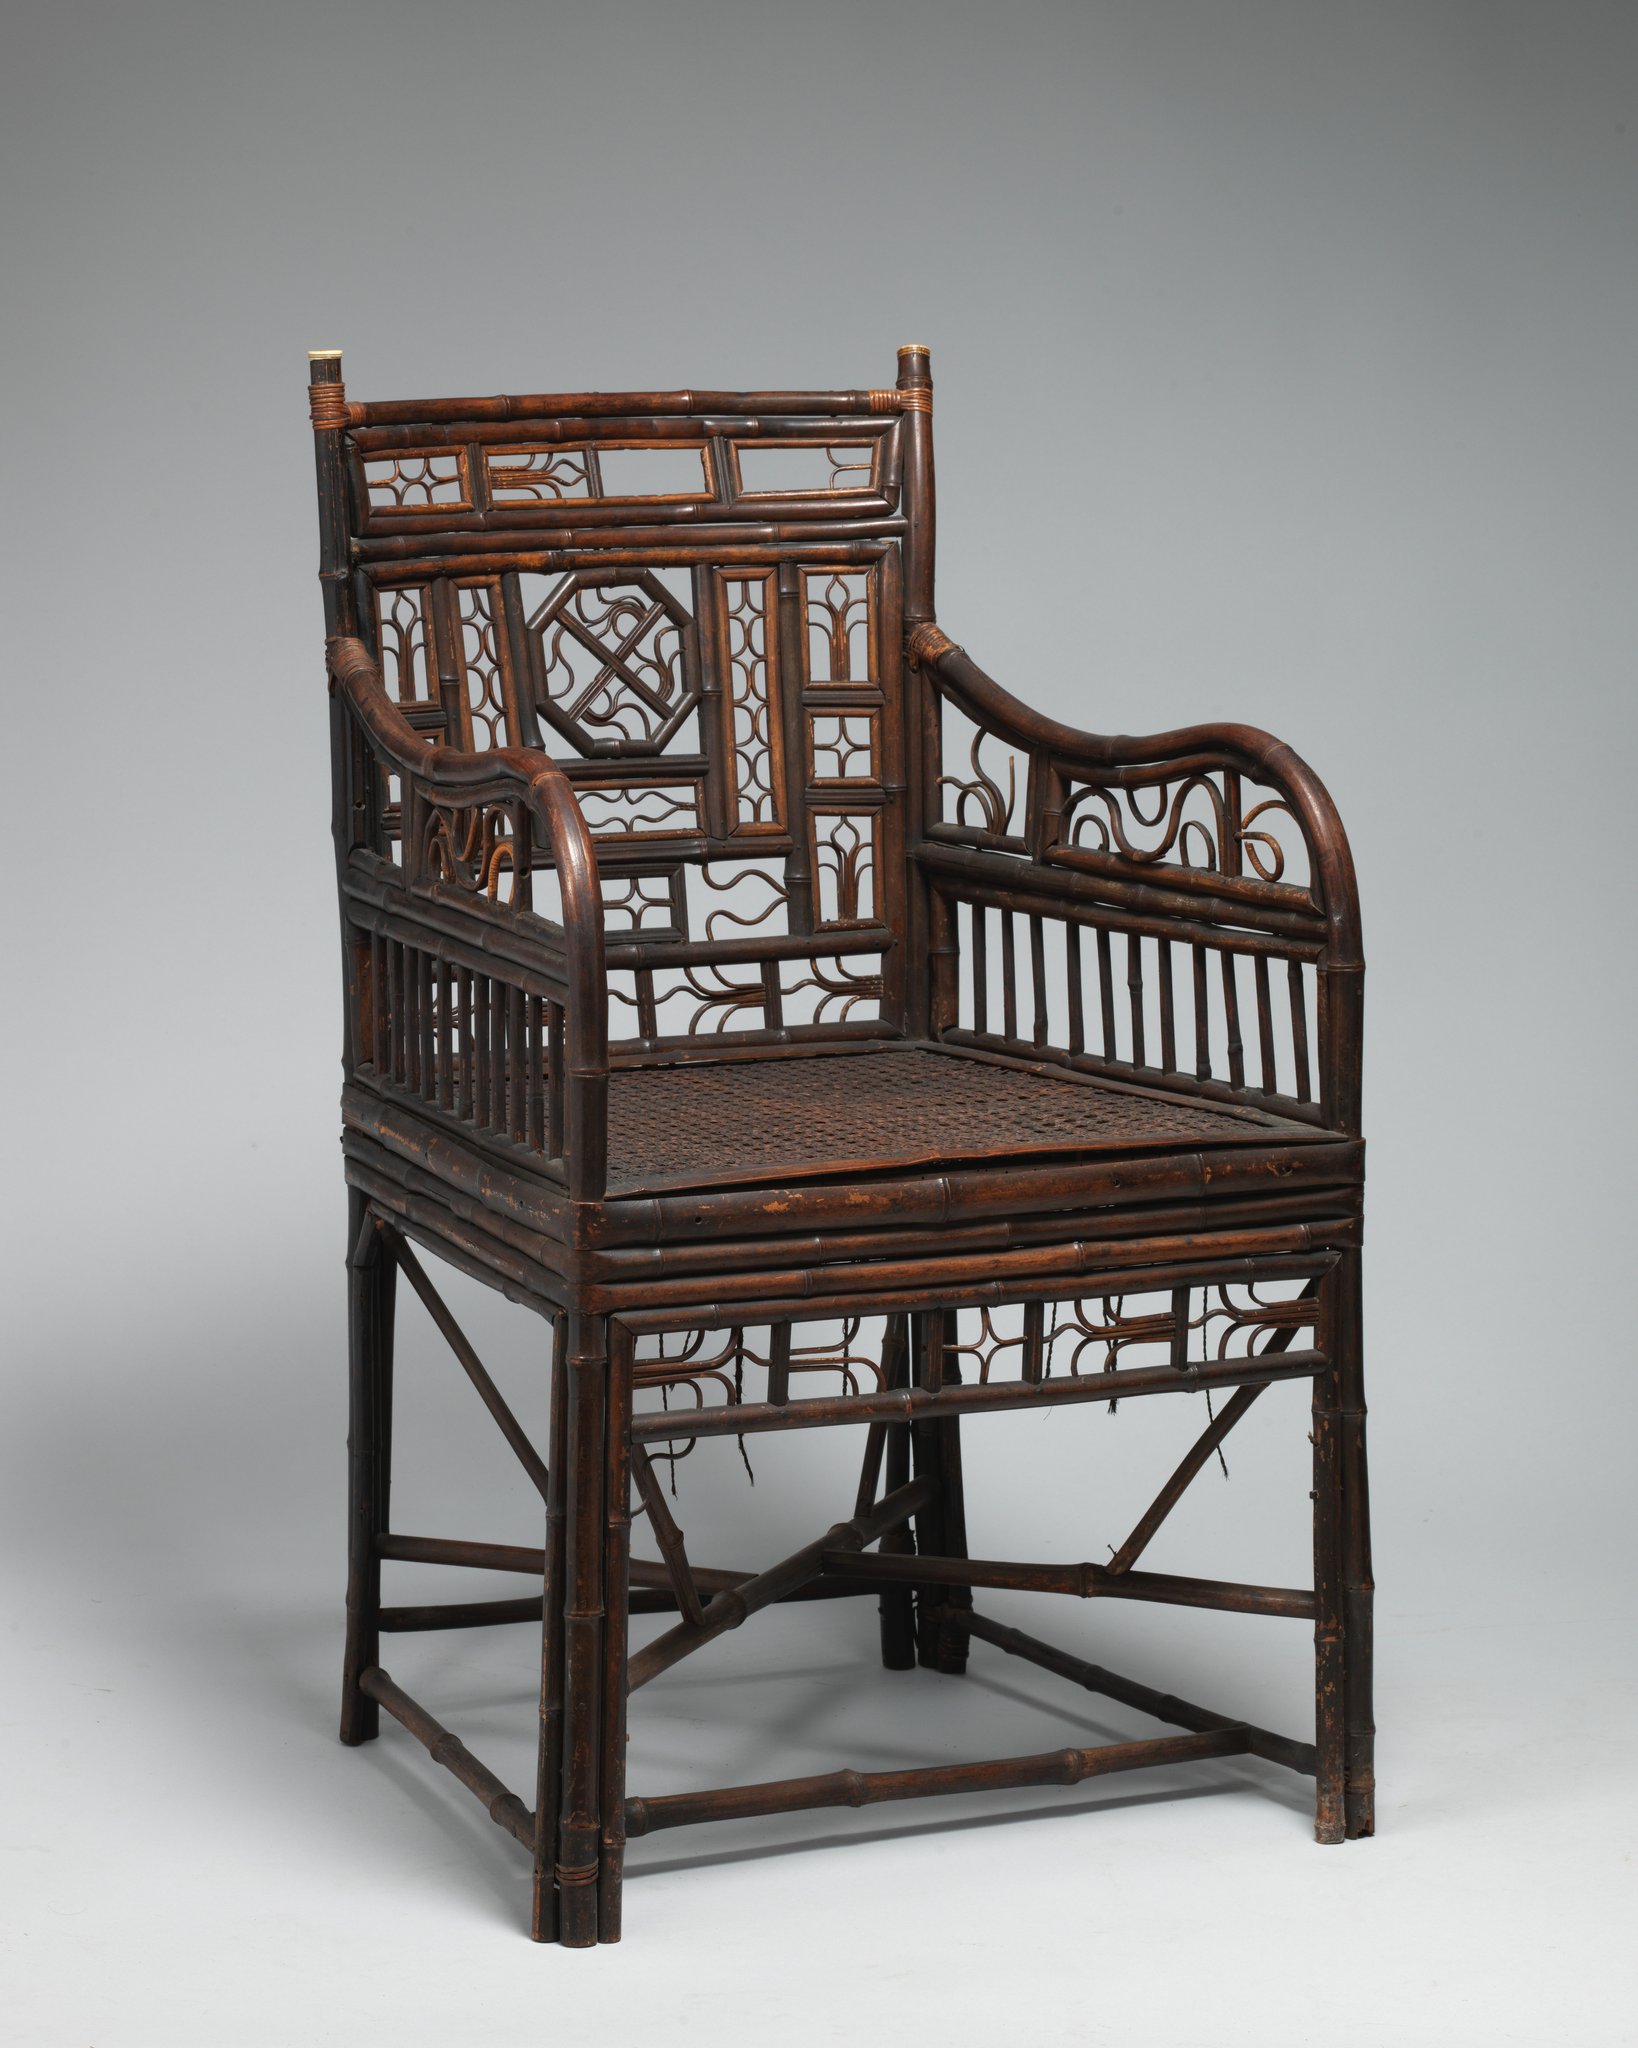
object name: armchair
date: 1767-1800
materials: bamboo, ivory, rattan